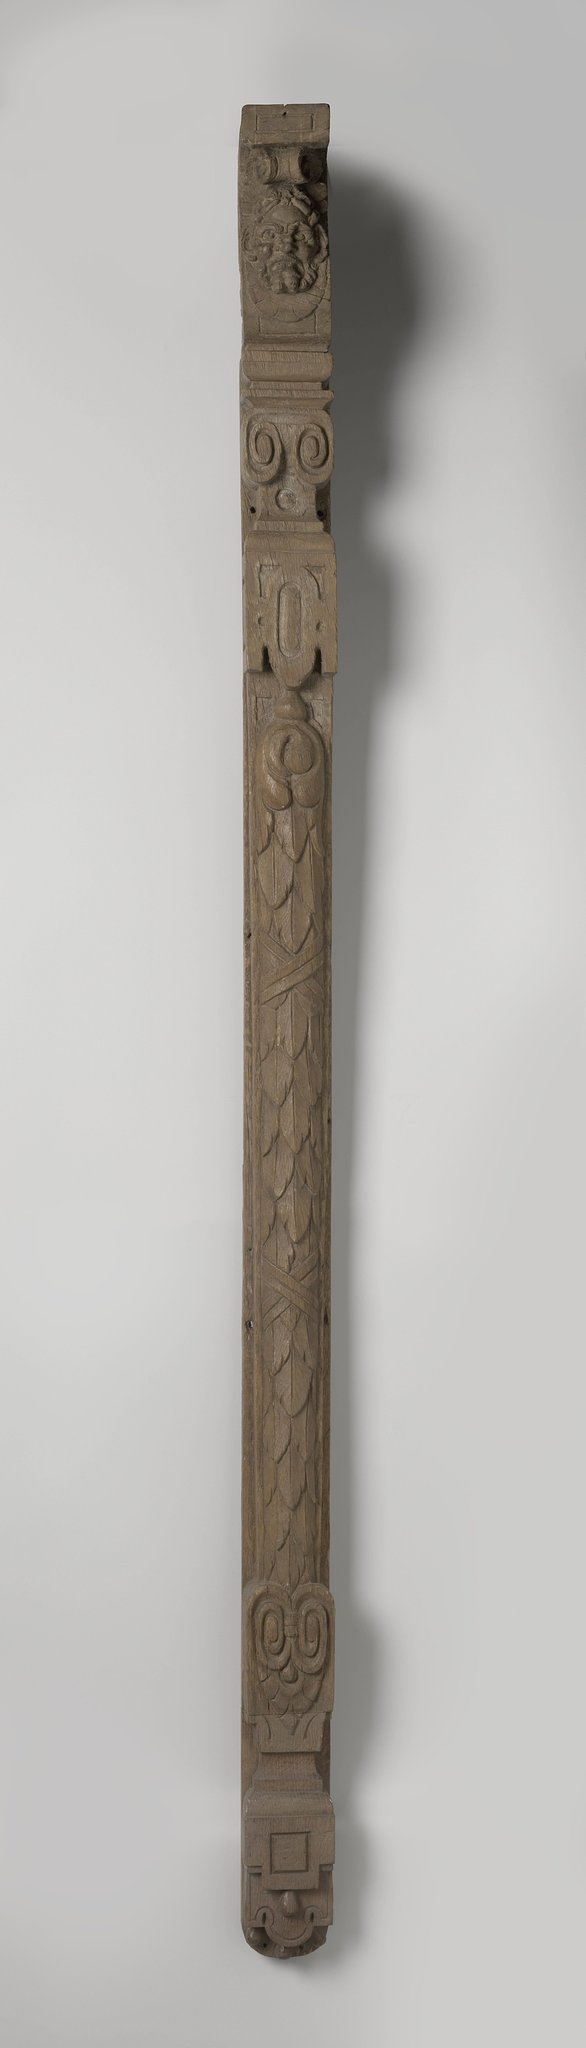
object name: stile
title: Gebeeldhouwde stijl van eikenhout, afkomstig uit het z.g. Huis van Alva, Warmoestraat te Amsterdam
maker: Anonymous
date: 1500-1699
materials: wood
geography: northern netherlands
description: Gebeeldhouwde eikenhouten stijl zonder afwerking, afkomstig uit het z.g. Huis van Alva, Warmoestraat te Amsterdam. In totaal gaat het om twee consoles, drie brede en drie smalle stijlen (BK-KOG-755-A t/m C, E t/m H). Zie tevens BK-KOG-754-1 t/m 7, dit zijn 6 beschilderde stijlen die uit hetzelfde huis afkomstig zijn.